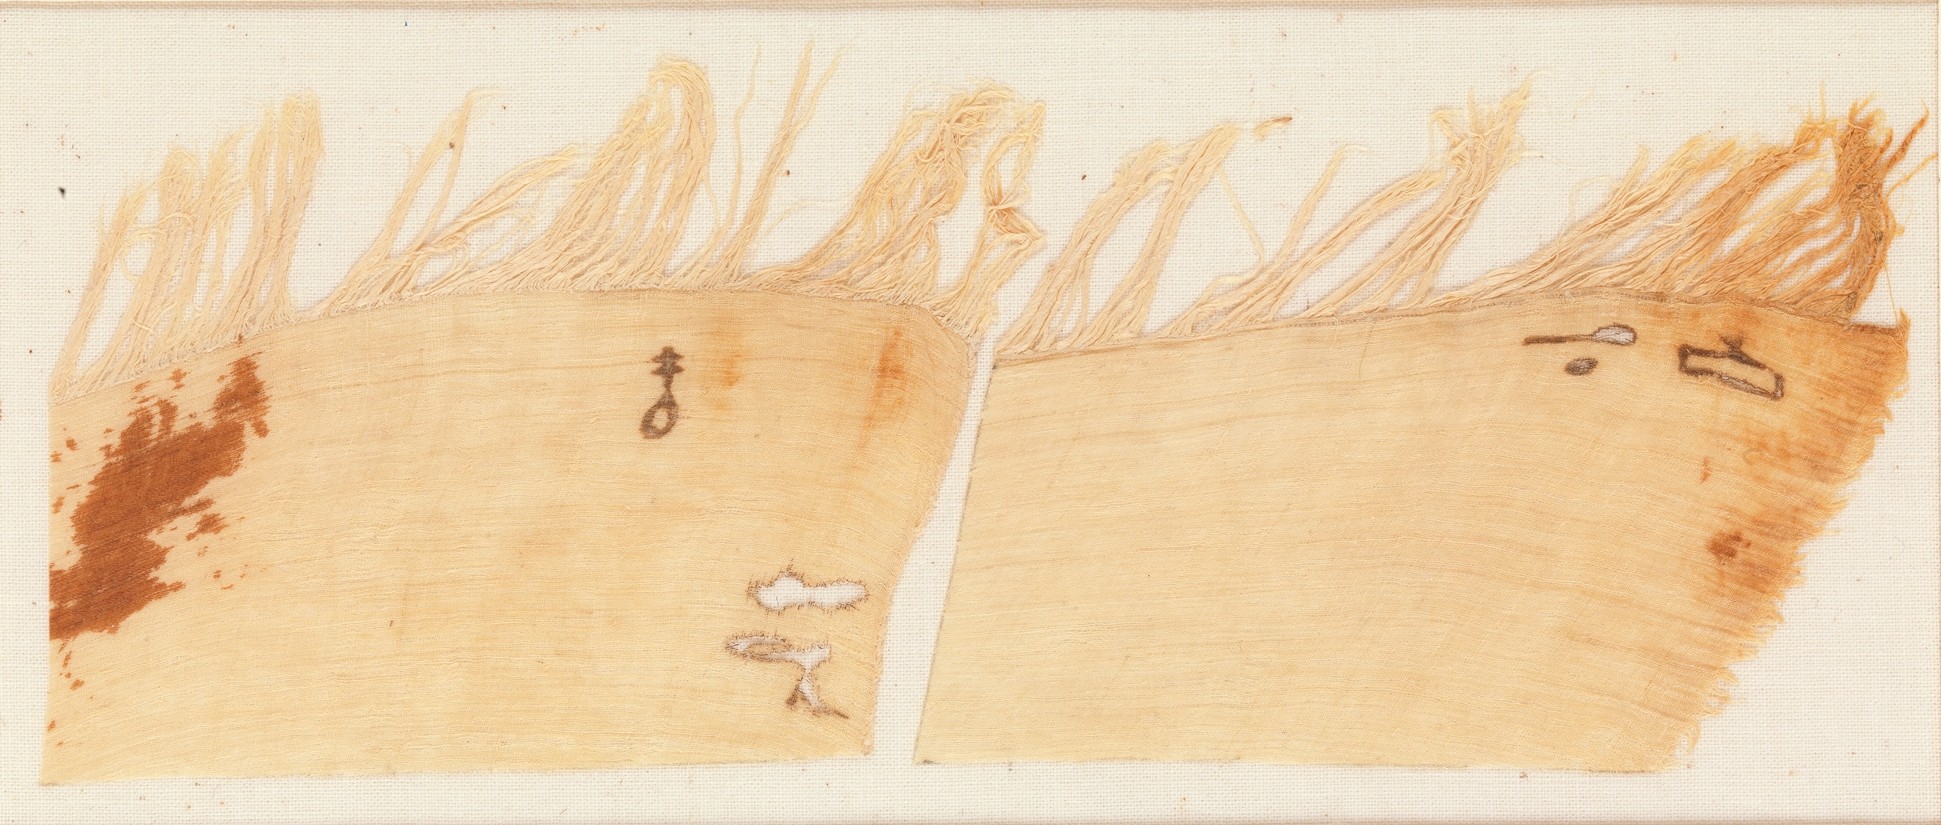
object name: linen mark, wah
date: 1981-1975 BCE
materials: linen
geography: egypt